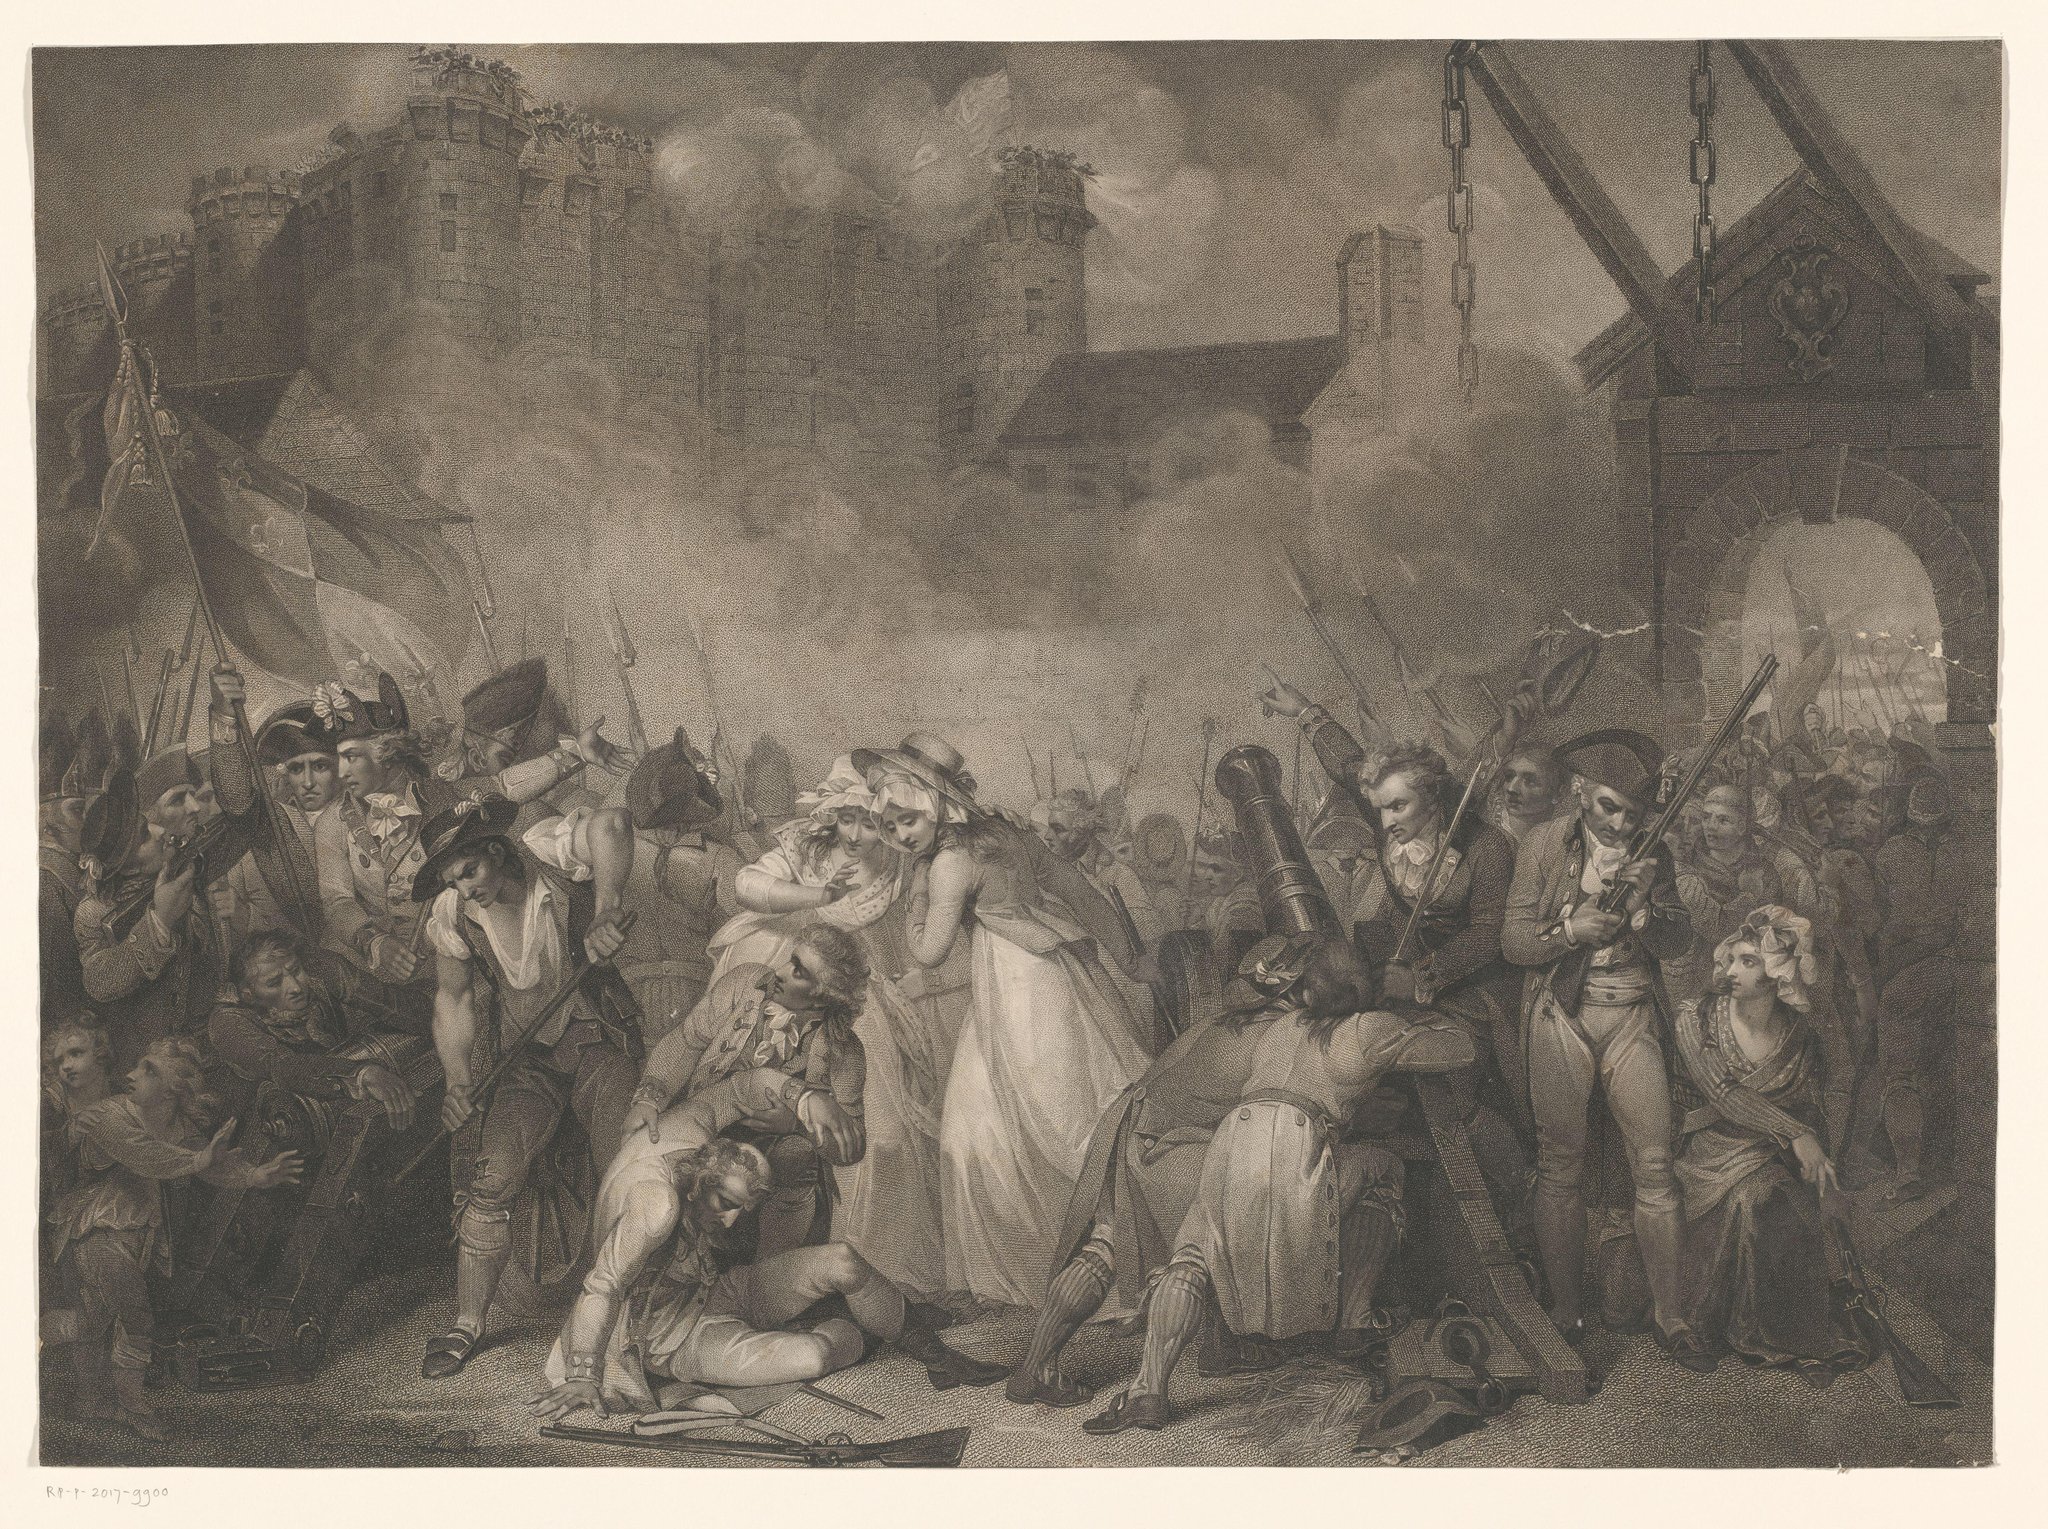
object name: print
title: Bestorming van de Bastille, 14 juli 1789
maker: william nutter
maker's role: print maker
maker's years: 1754-1802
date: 1792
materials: paper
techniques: engraving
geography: england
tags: (military) attack, street-fights, riots, destruction of buildings (~ revolutionary action)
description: Bestorming van de Bastille, 14 juli 1789. Op de voorgrond het verzamelde volk klaar om de gevangenis te bestormen. Vanuit de Bastille wordt door soldaten op de menigte geschoten.